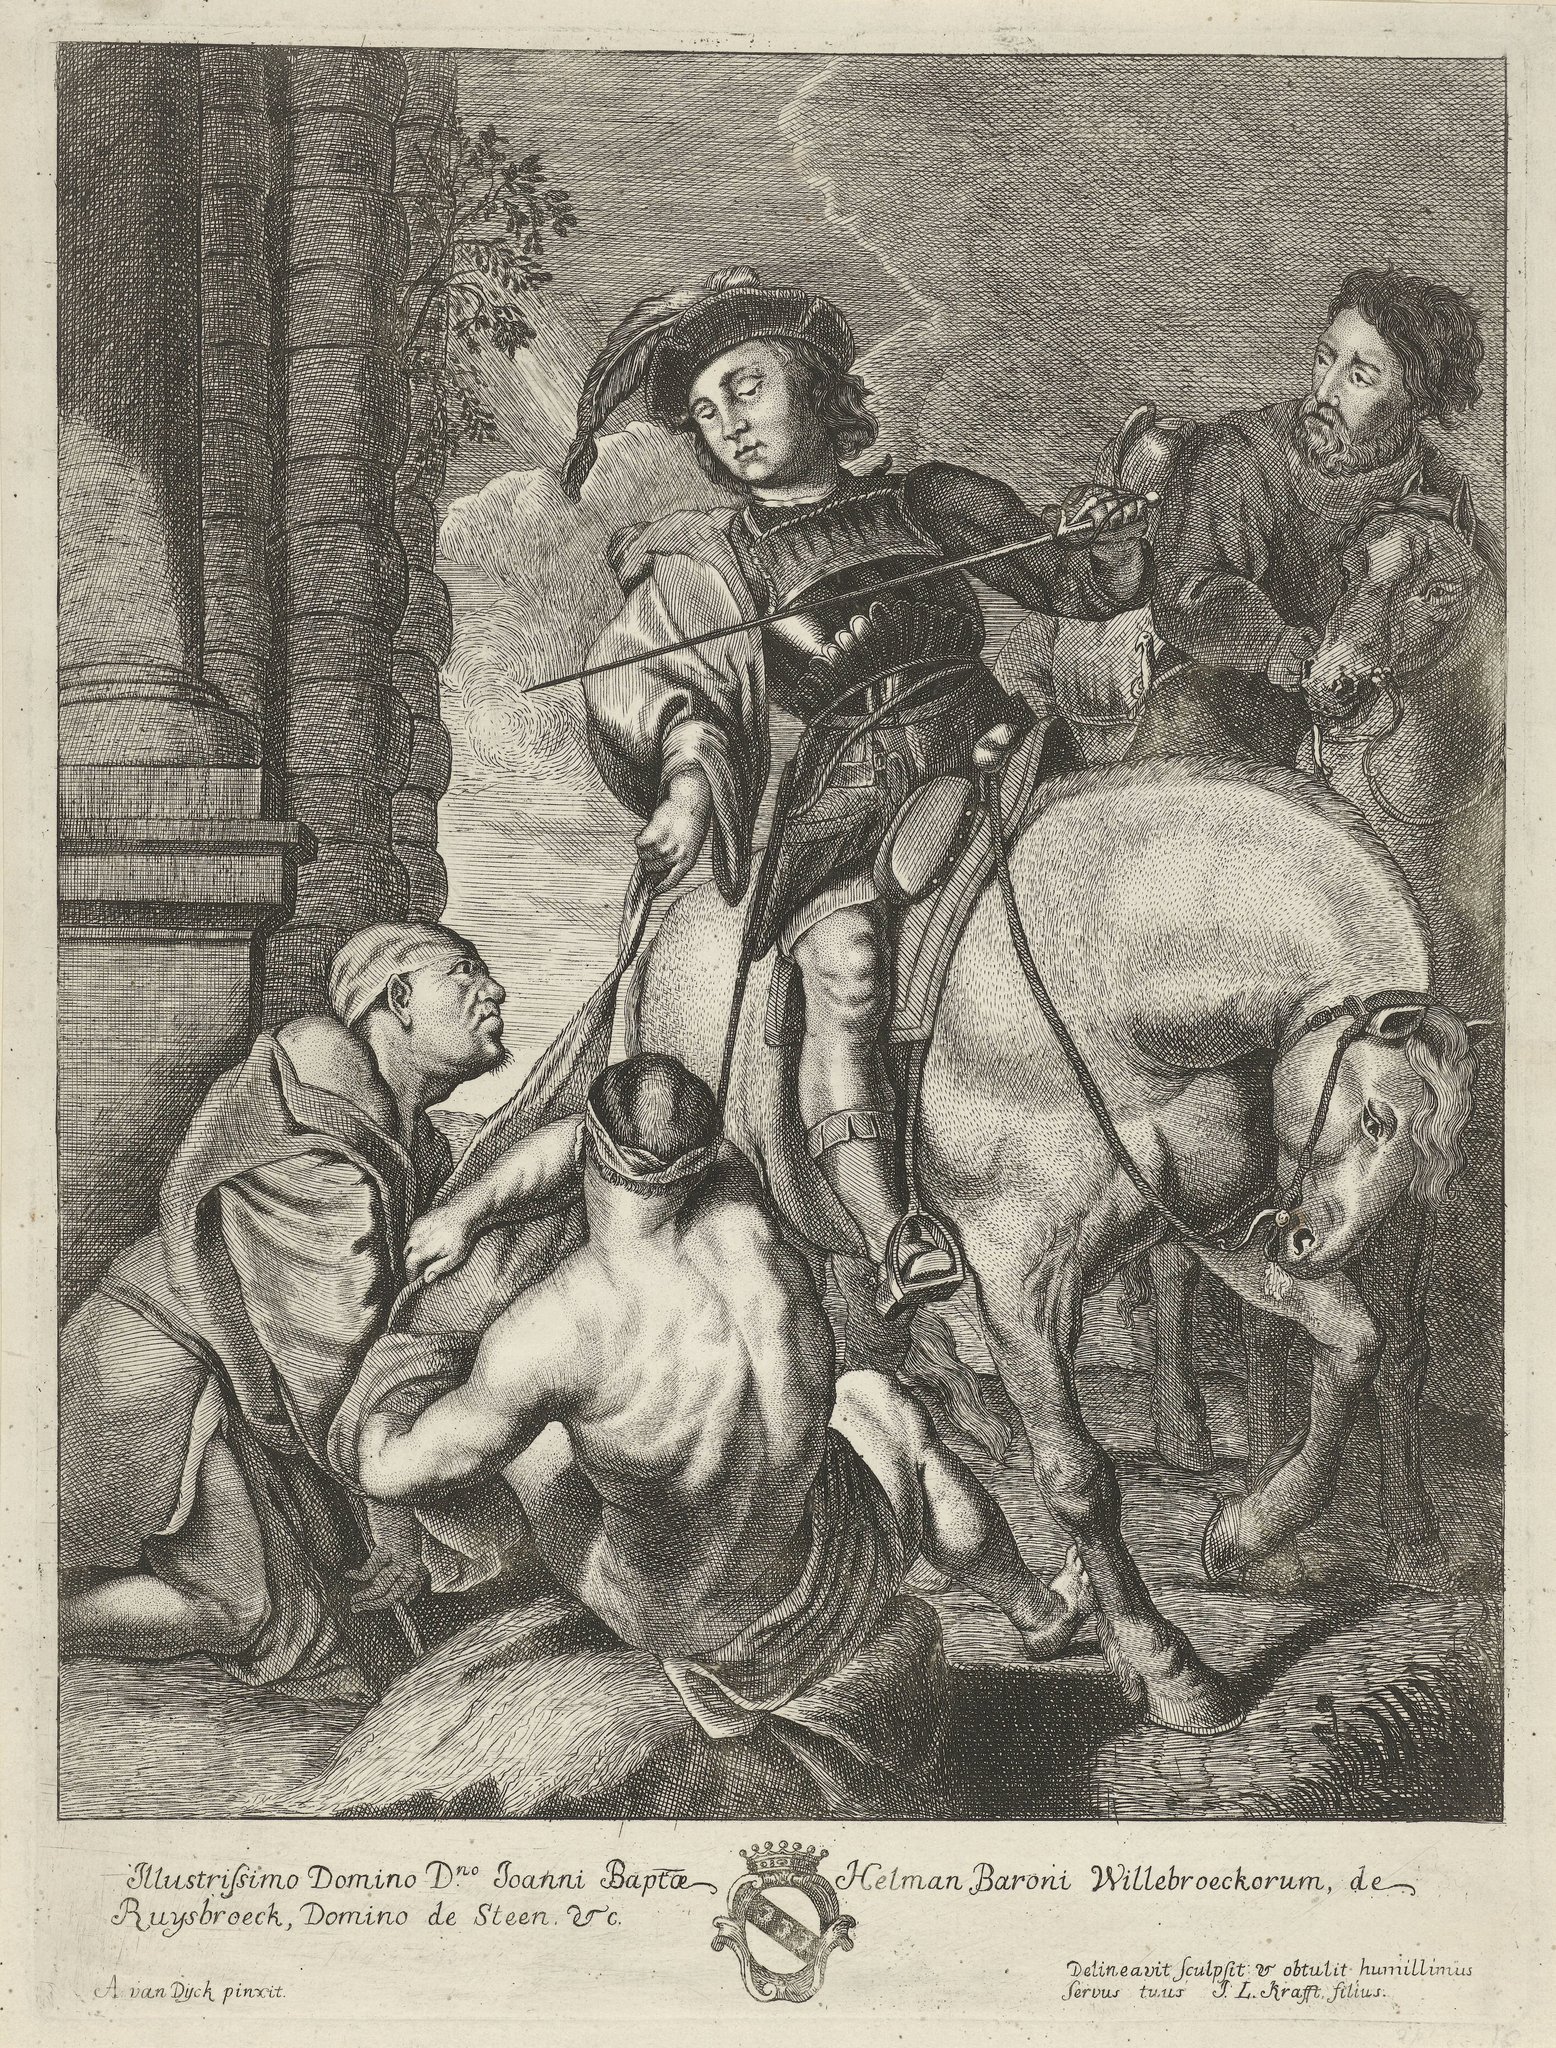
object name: print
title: Heilige Martinus deelt zijn mantel met een bedelaar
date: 1704-1765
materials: paper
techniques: etching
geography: southern netherlands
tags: st. martin divides his cloak (i.e. the charity of st. martin): he is usually shown on horseback, cutting his cloak with his sword, or putting part of the cloak round the shoulders of a beggar who kneels beside him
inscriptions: inscription: ‘Illustrissimo [...] de Steen’, collector's mark: Lugt 240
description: Vanaf zijn paard snijdt de Heilige Martinus (Sint Maarten) met zijn zwaard zijn mantel in tweeën, om een deel aan een bedelaar te geven. Onder de afbeelding drie regels tekst.